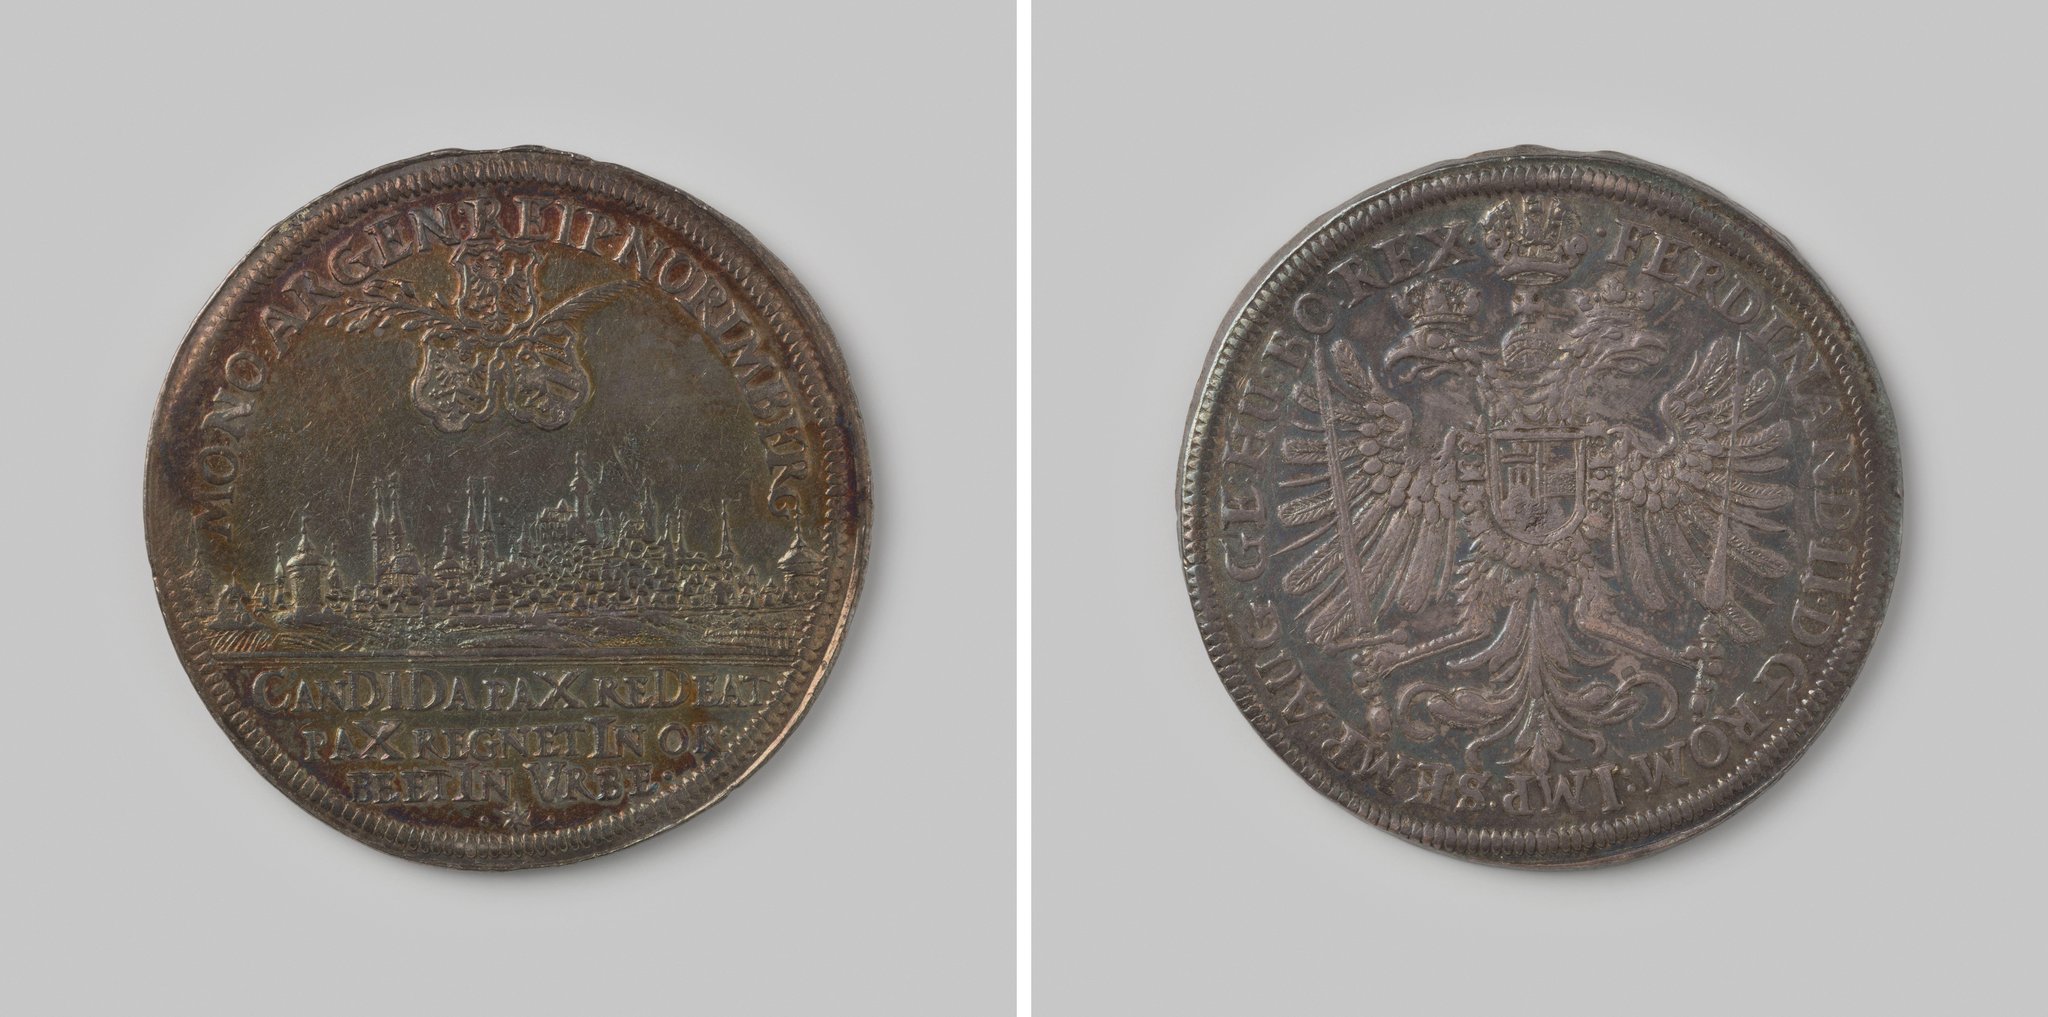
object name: taler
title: Taler uit de rijksstad Neurenberg op naam van keizer Ferdinand II, 1628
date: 1628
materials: silver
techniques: striking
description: Zilveren munt. Voorzijde: stadsgezicht, met in afsnede spreuk in drie regels, waarin jaartal in Romeinse cijfers schuilgaat. Aan bovenzijde tussen twee takken drie wapenschilden. Keerzijde: gekroonde dubbelkoppige adelaar met in de poten een scepter en een zwaard en op de borst een door keten en juweel van de orde van het gulden vlies omhangen wapenschild.